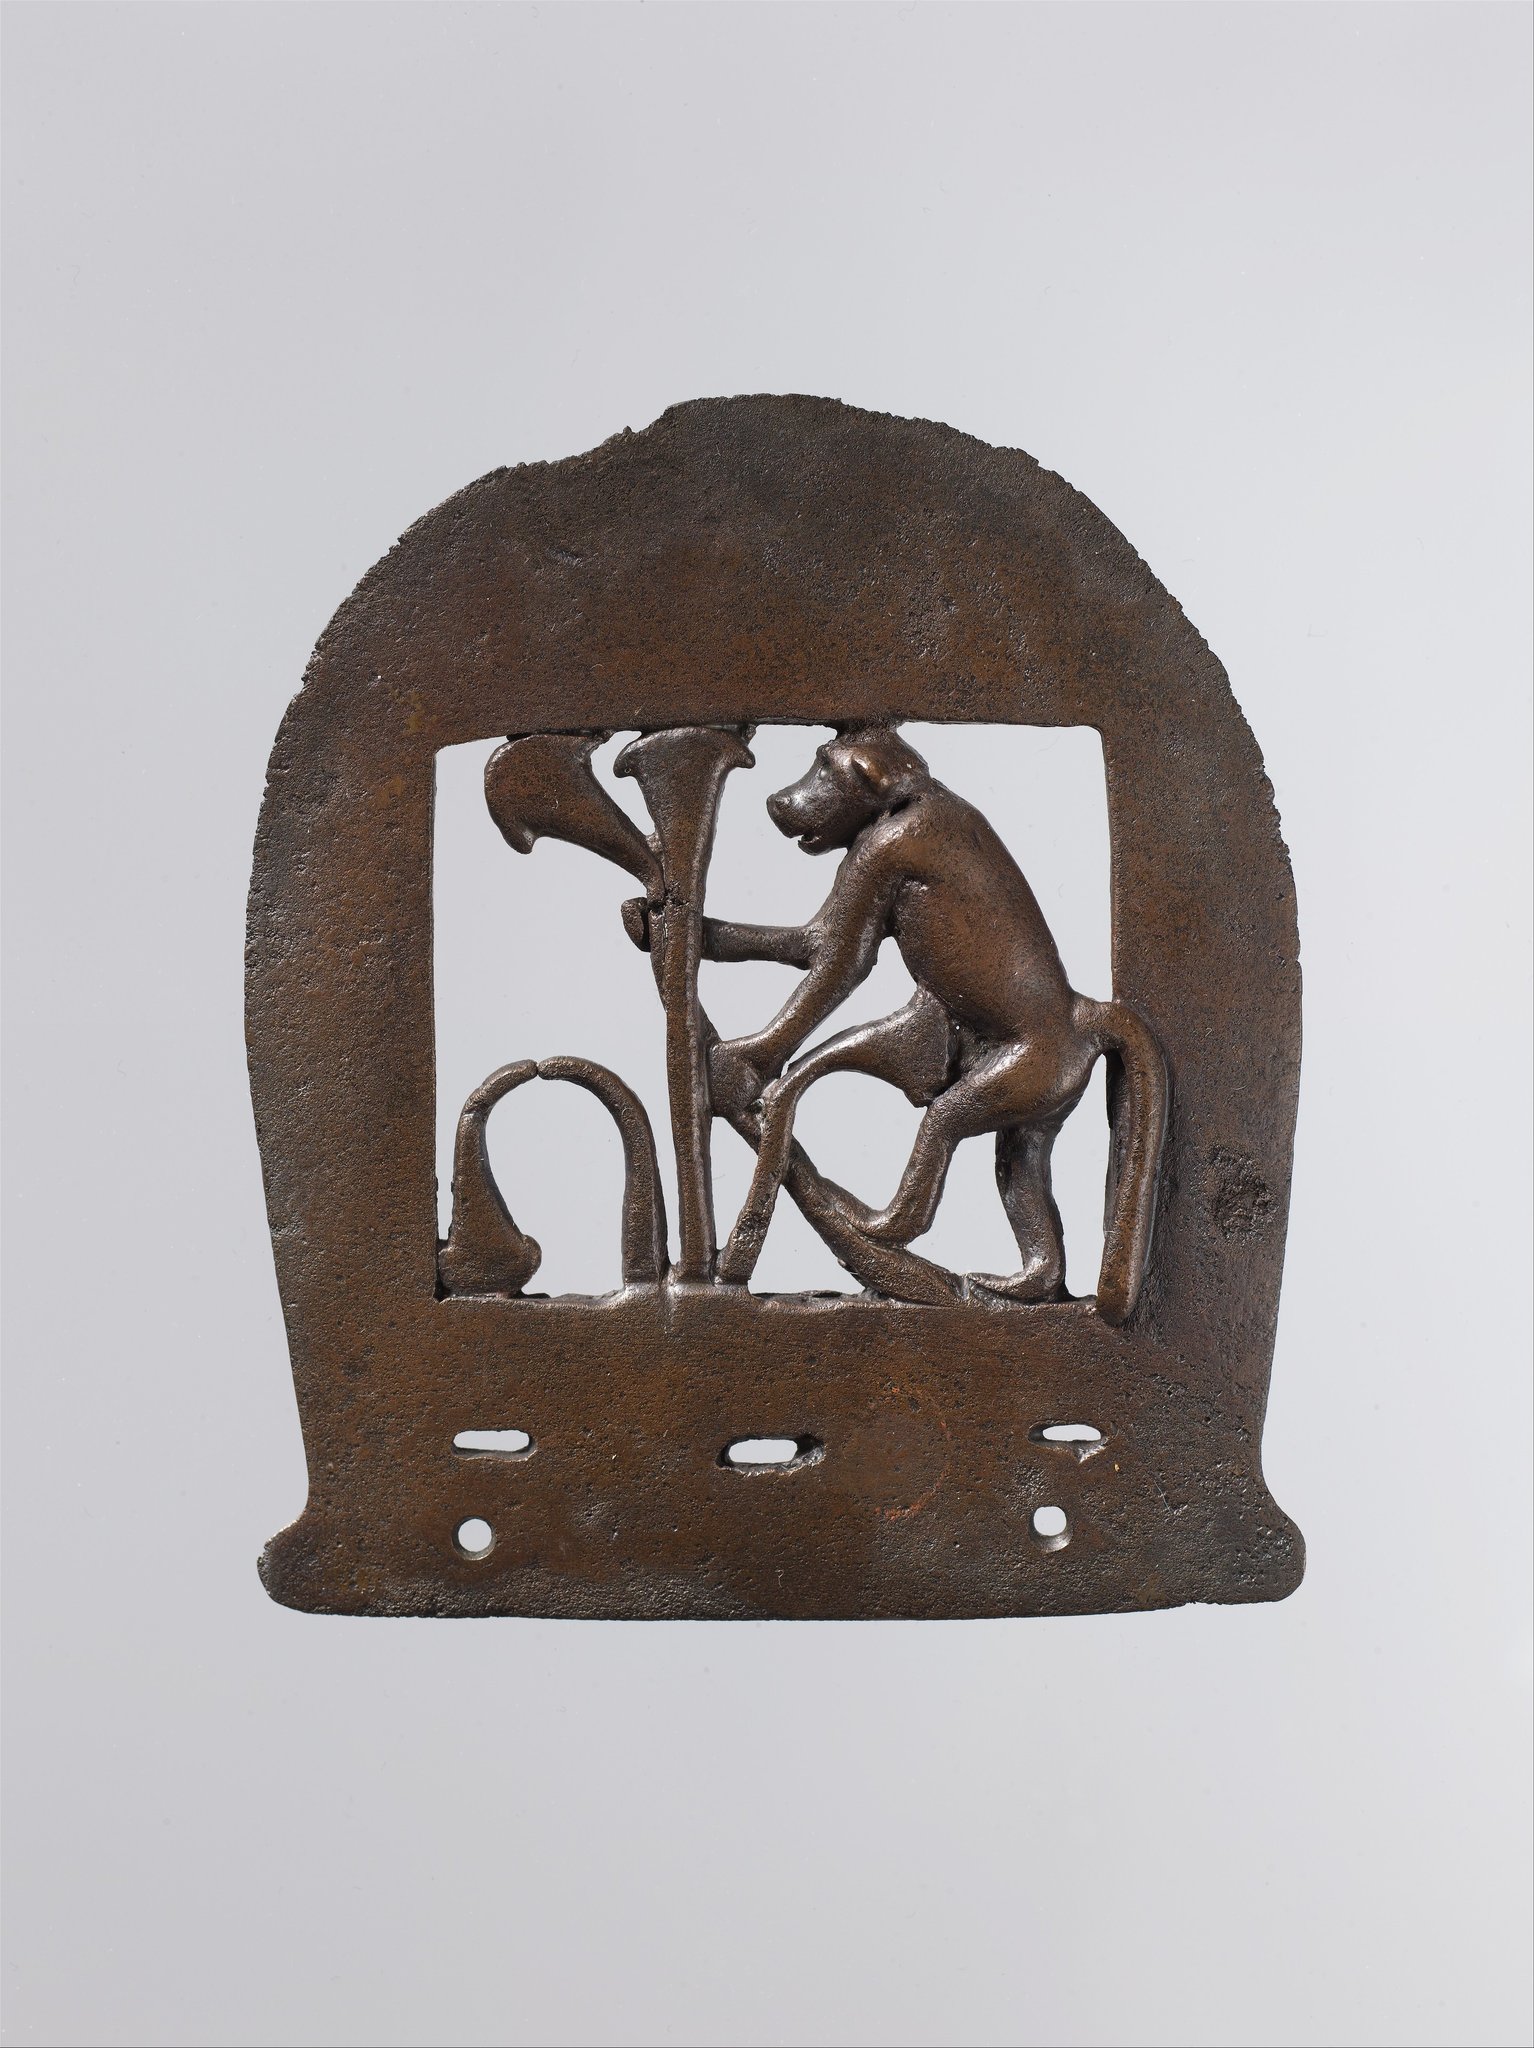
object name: ax head with monkey figure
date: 1981-1640 BCE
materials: bronze, copper alloy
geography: egypt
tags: monkeys